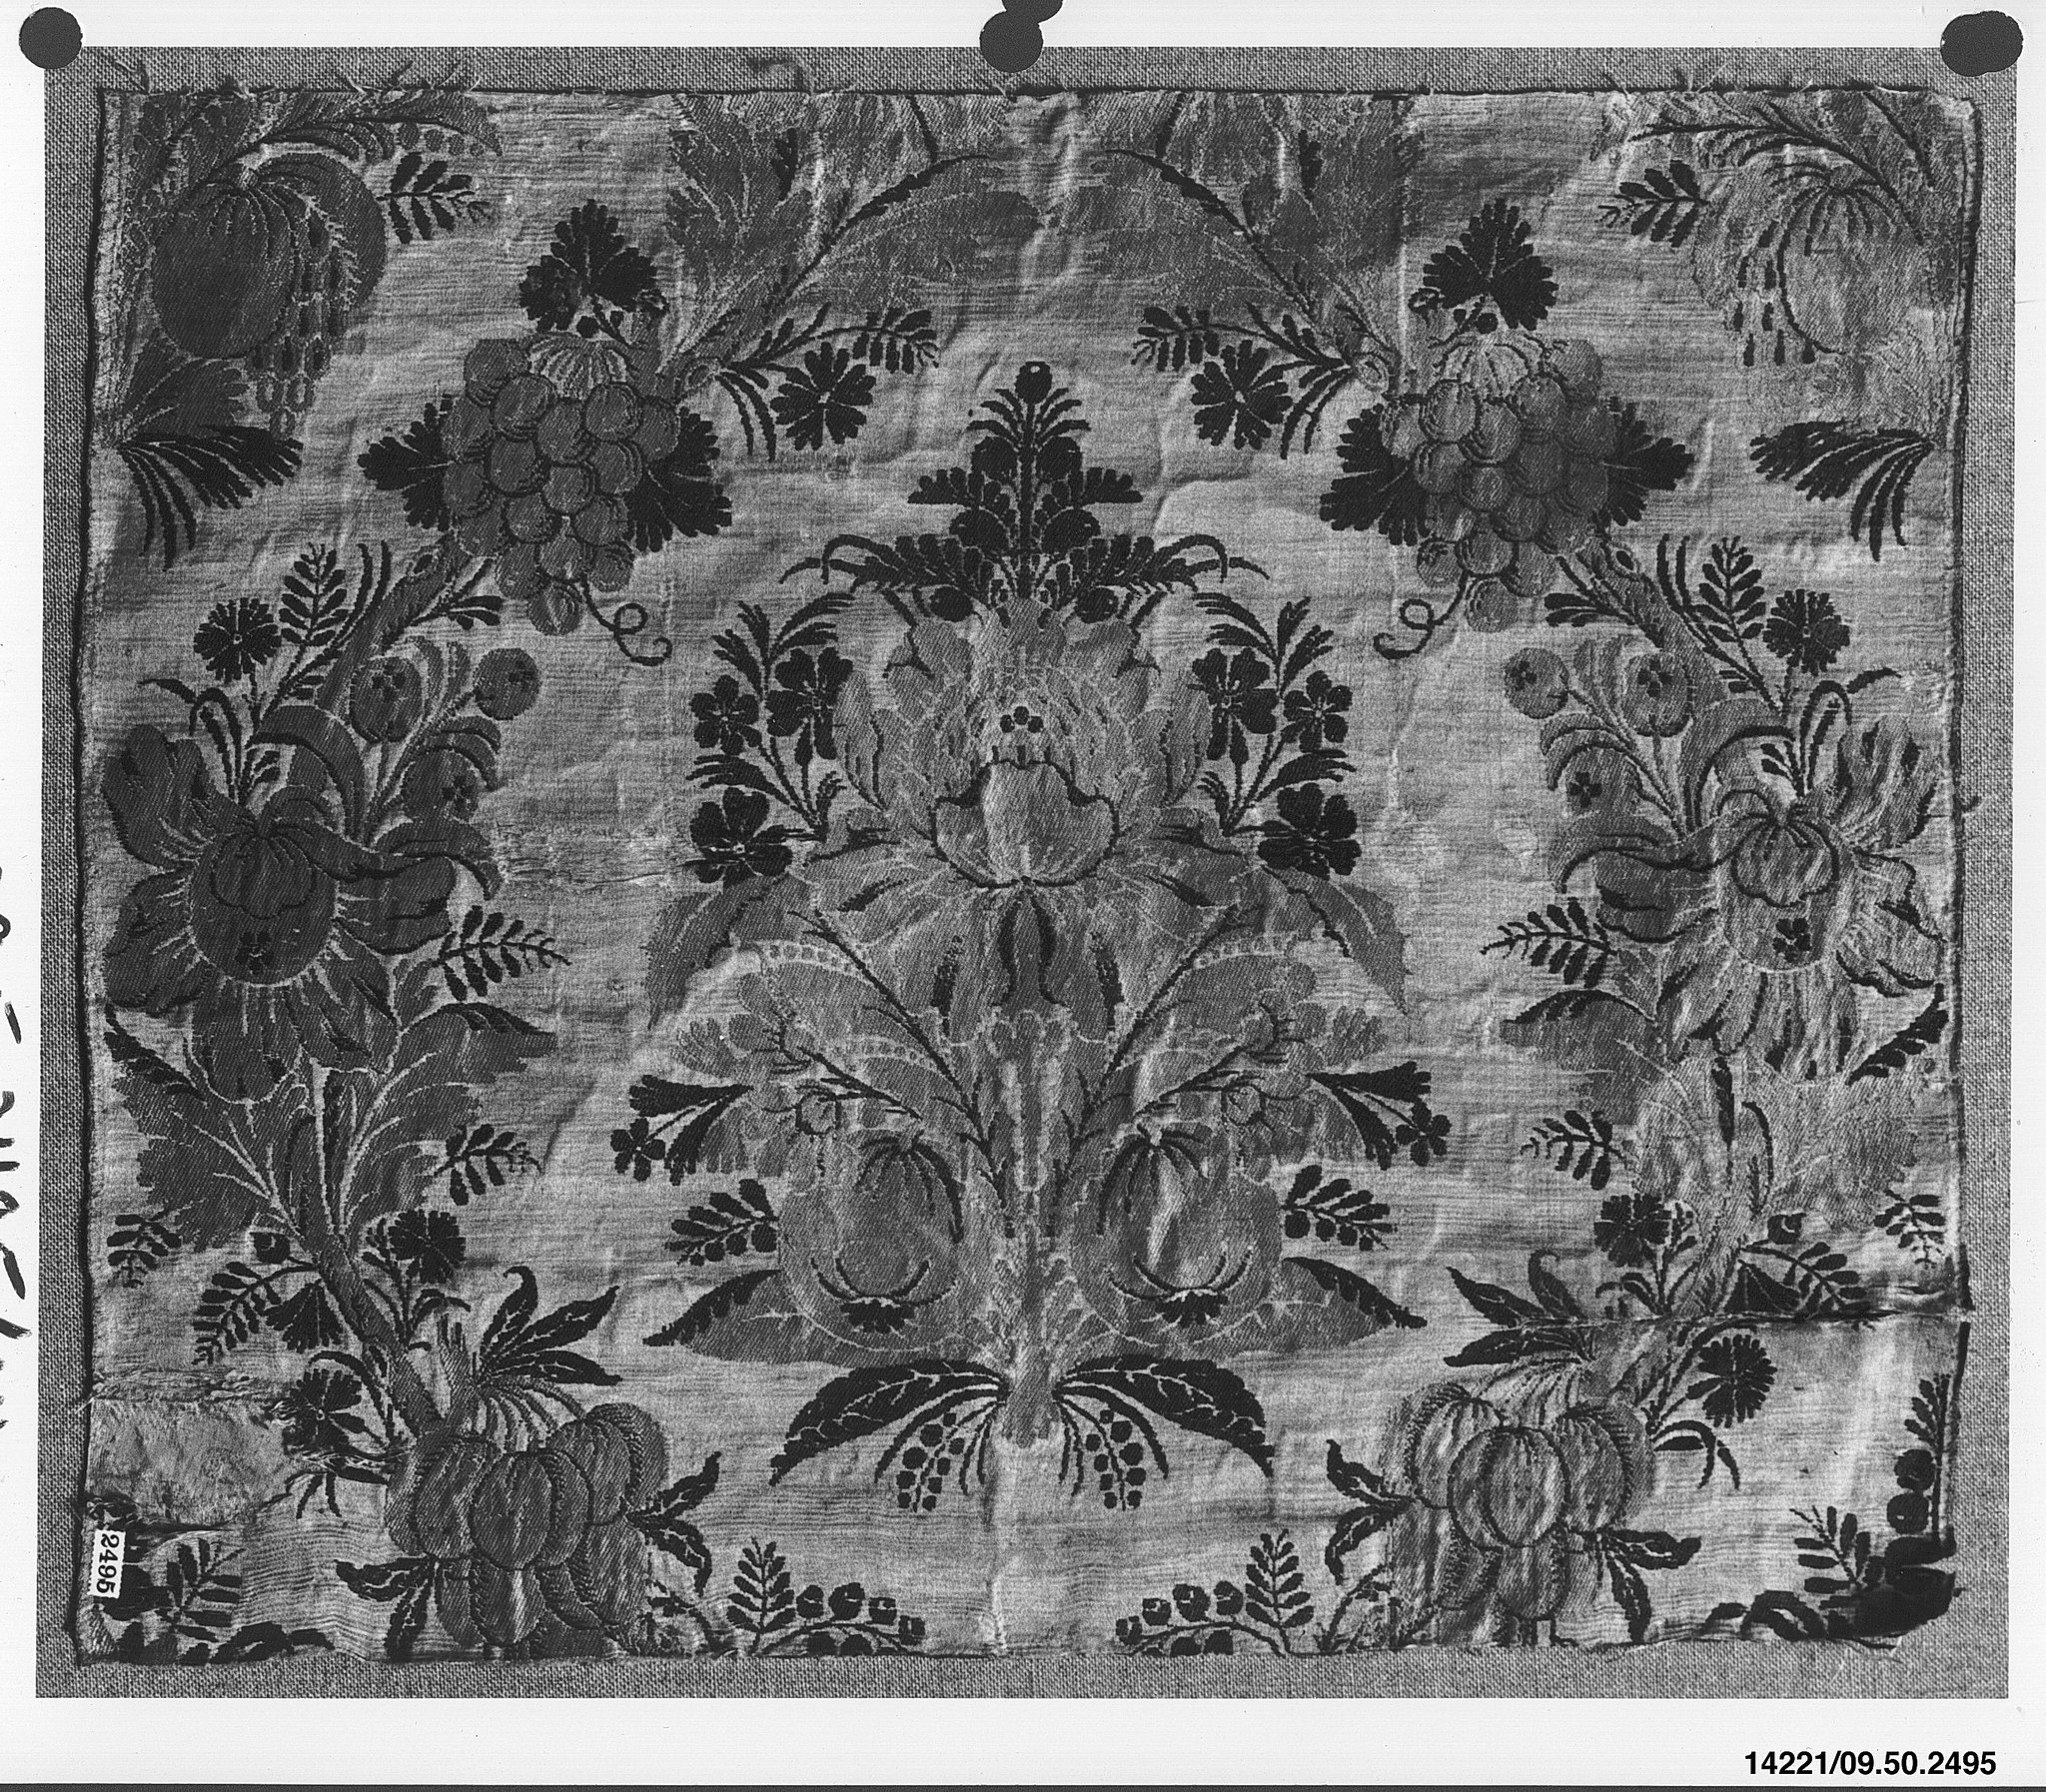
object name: piece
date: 1701-1800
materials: silk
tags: fruit,flowers,leaves